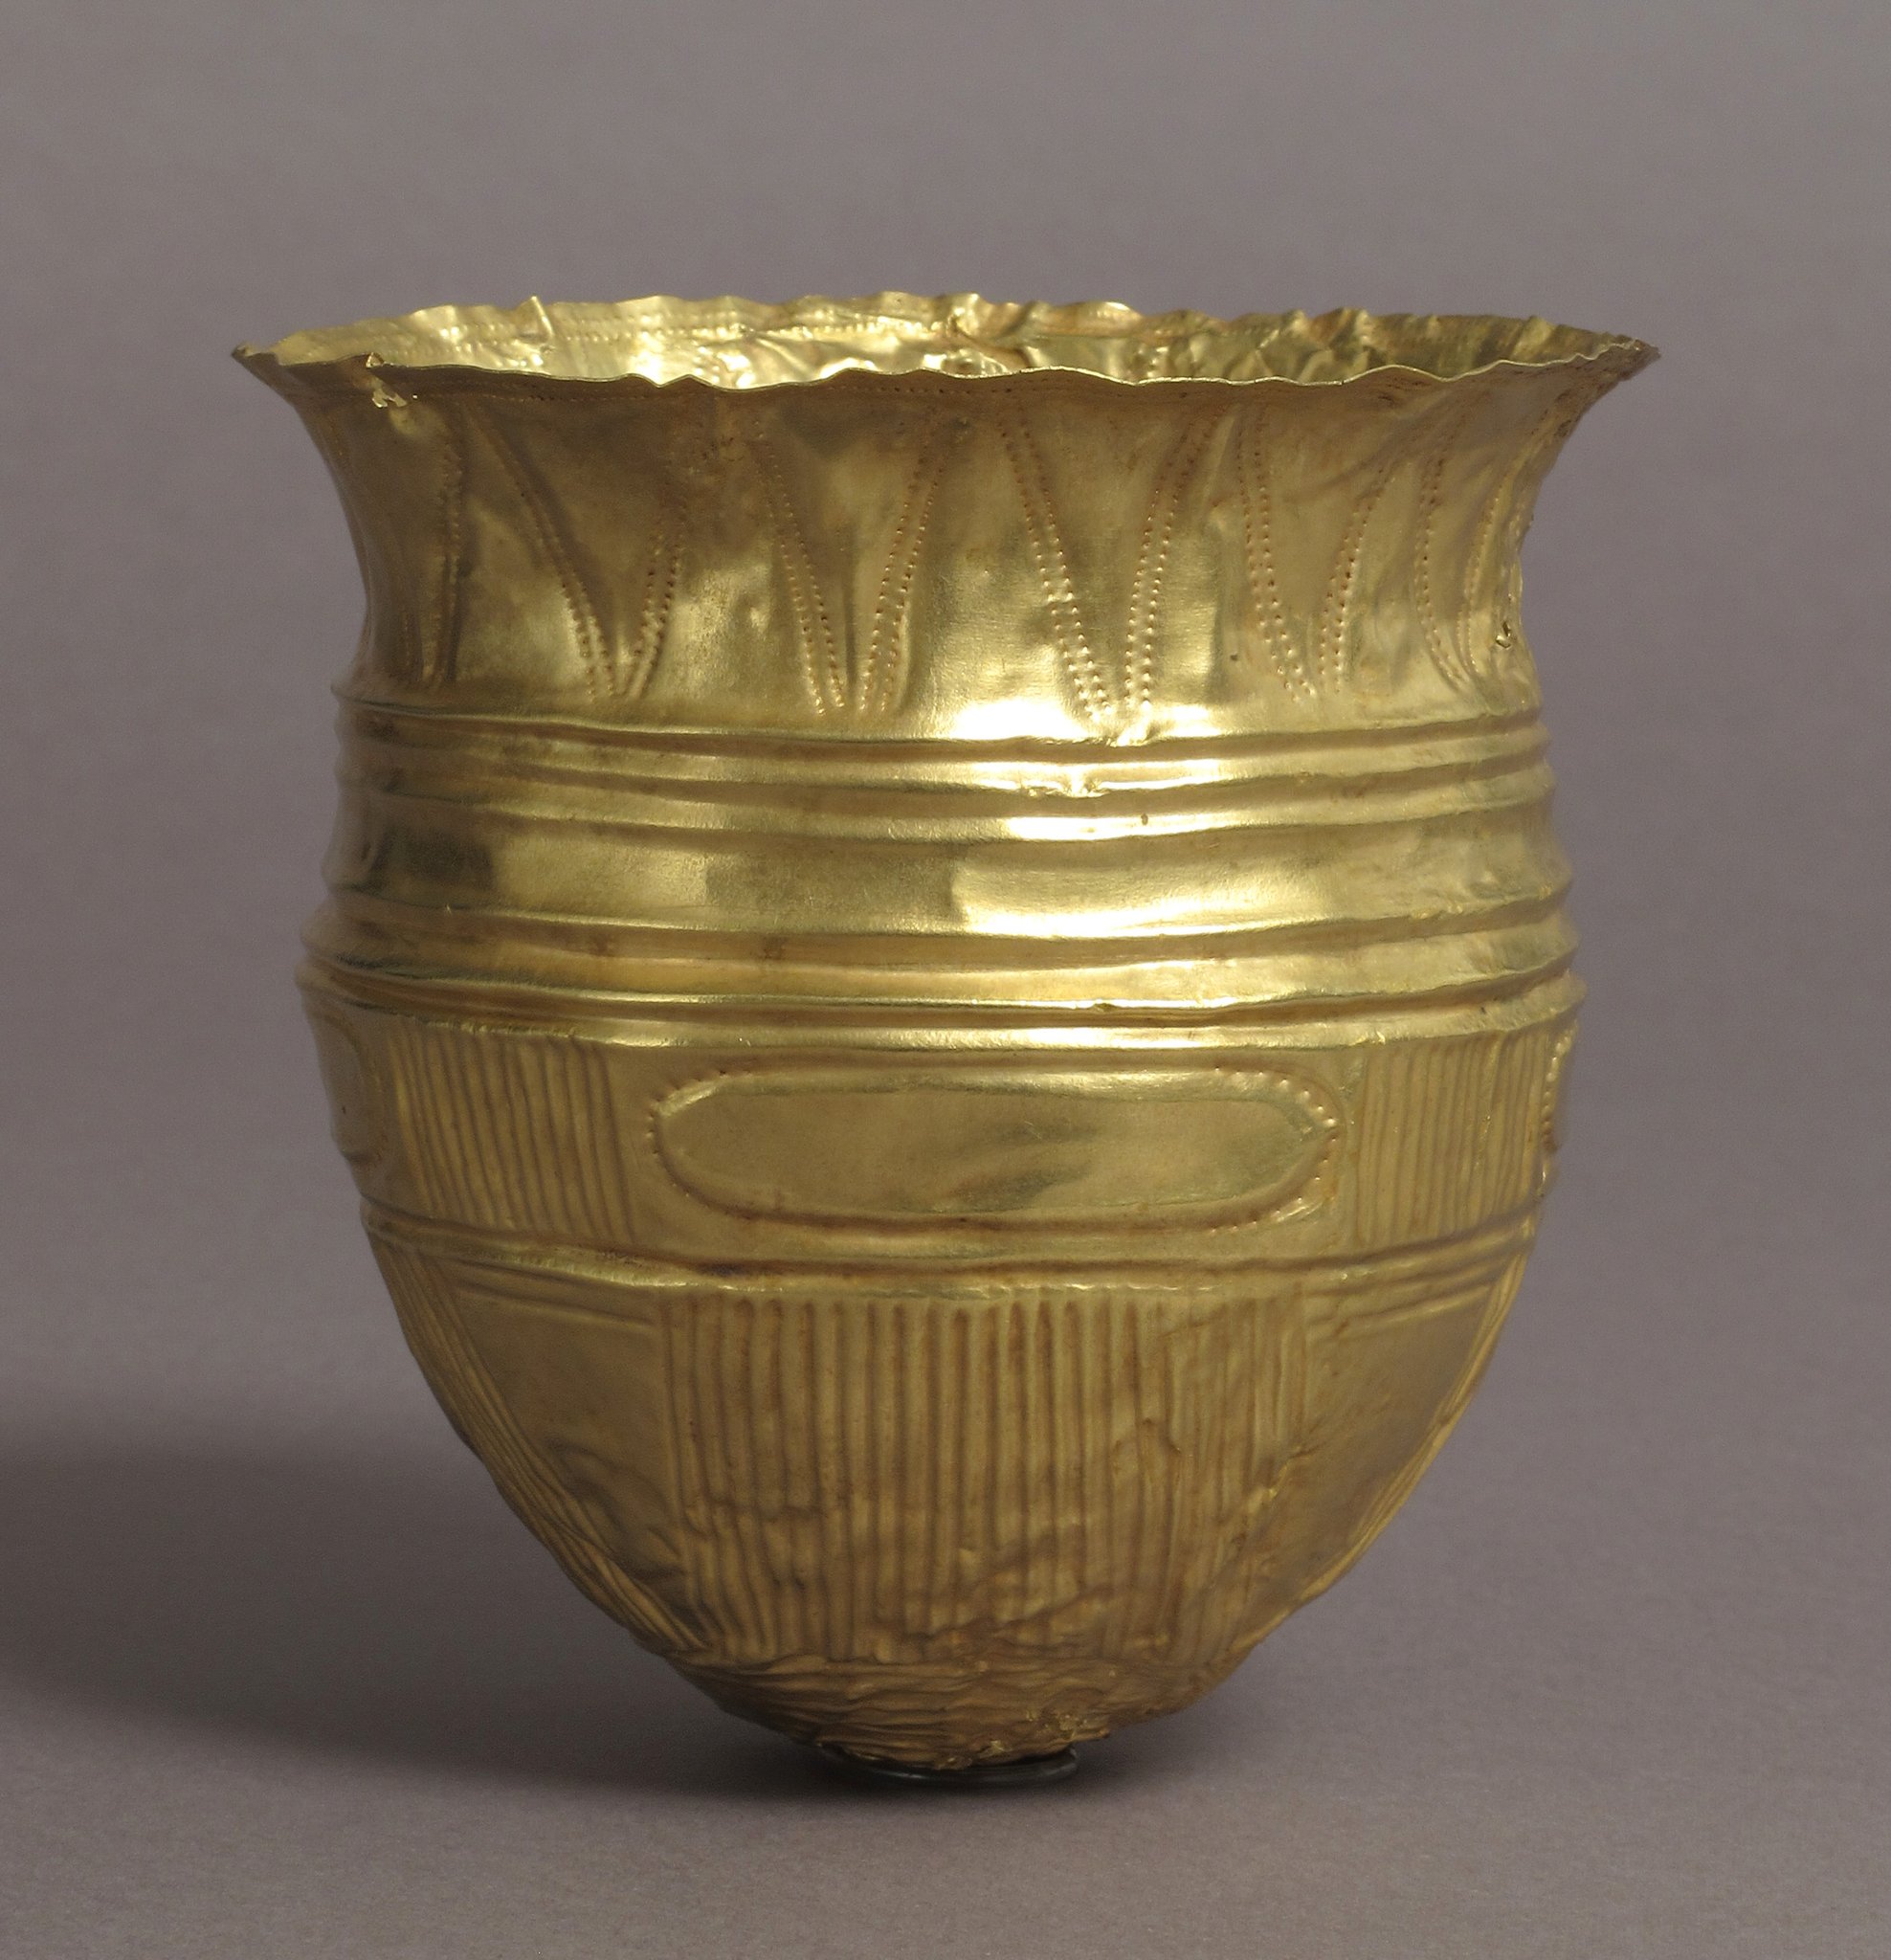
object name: vessel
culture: bronze age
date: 1750-1500 BCE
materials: gold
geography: central europe